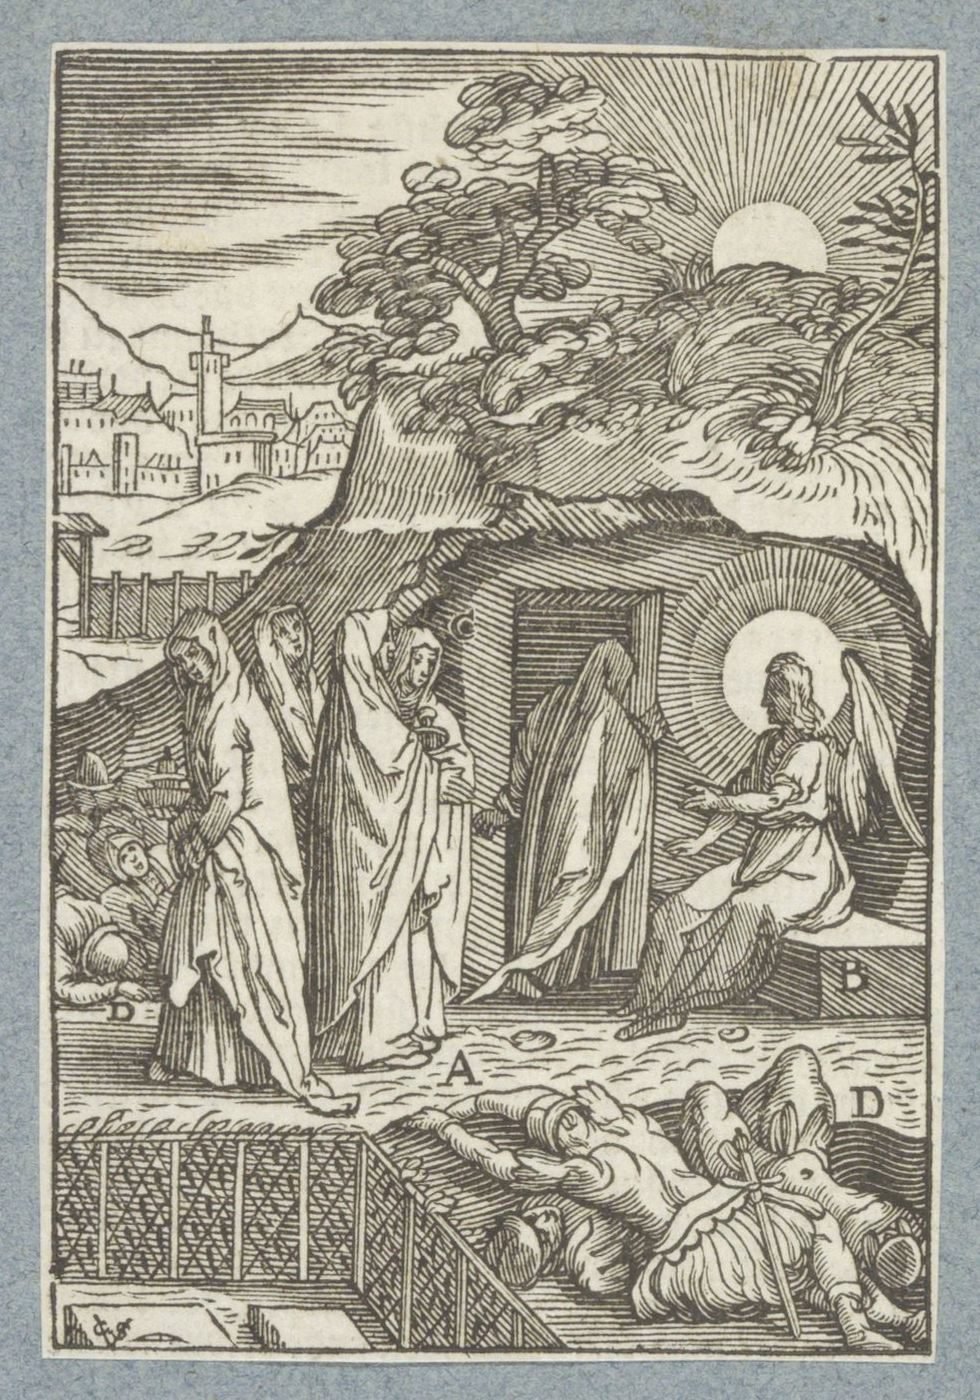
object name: print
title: Drie Maria's bij het lege graf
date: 1629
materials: paper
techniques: letterpress printing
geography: amsterdam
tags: angel(s) addressing the holy women ~ resurrection of christ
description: Na de sabbat komen de drie Maria's kijken naar het graf van Christus. Een engel is afgedaald uit de hemel en heeft de steen voor het graf weggerold. De bewakers liggen dood op de grond. De engel vertelt de drie Maria's dat Christus is opgestaan uit de dood. Bij verschillende elementen uit de voorstelling staan letters. De prent maakt deel uit van een album.